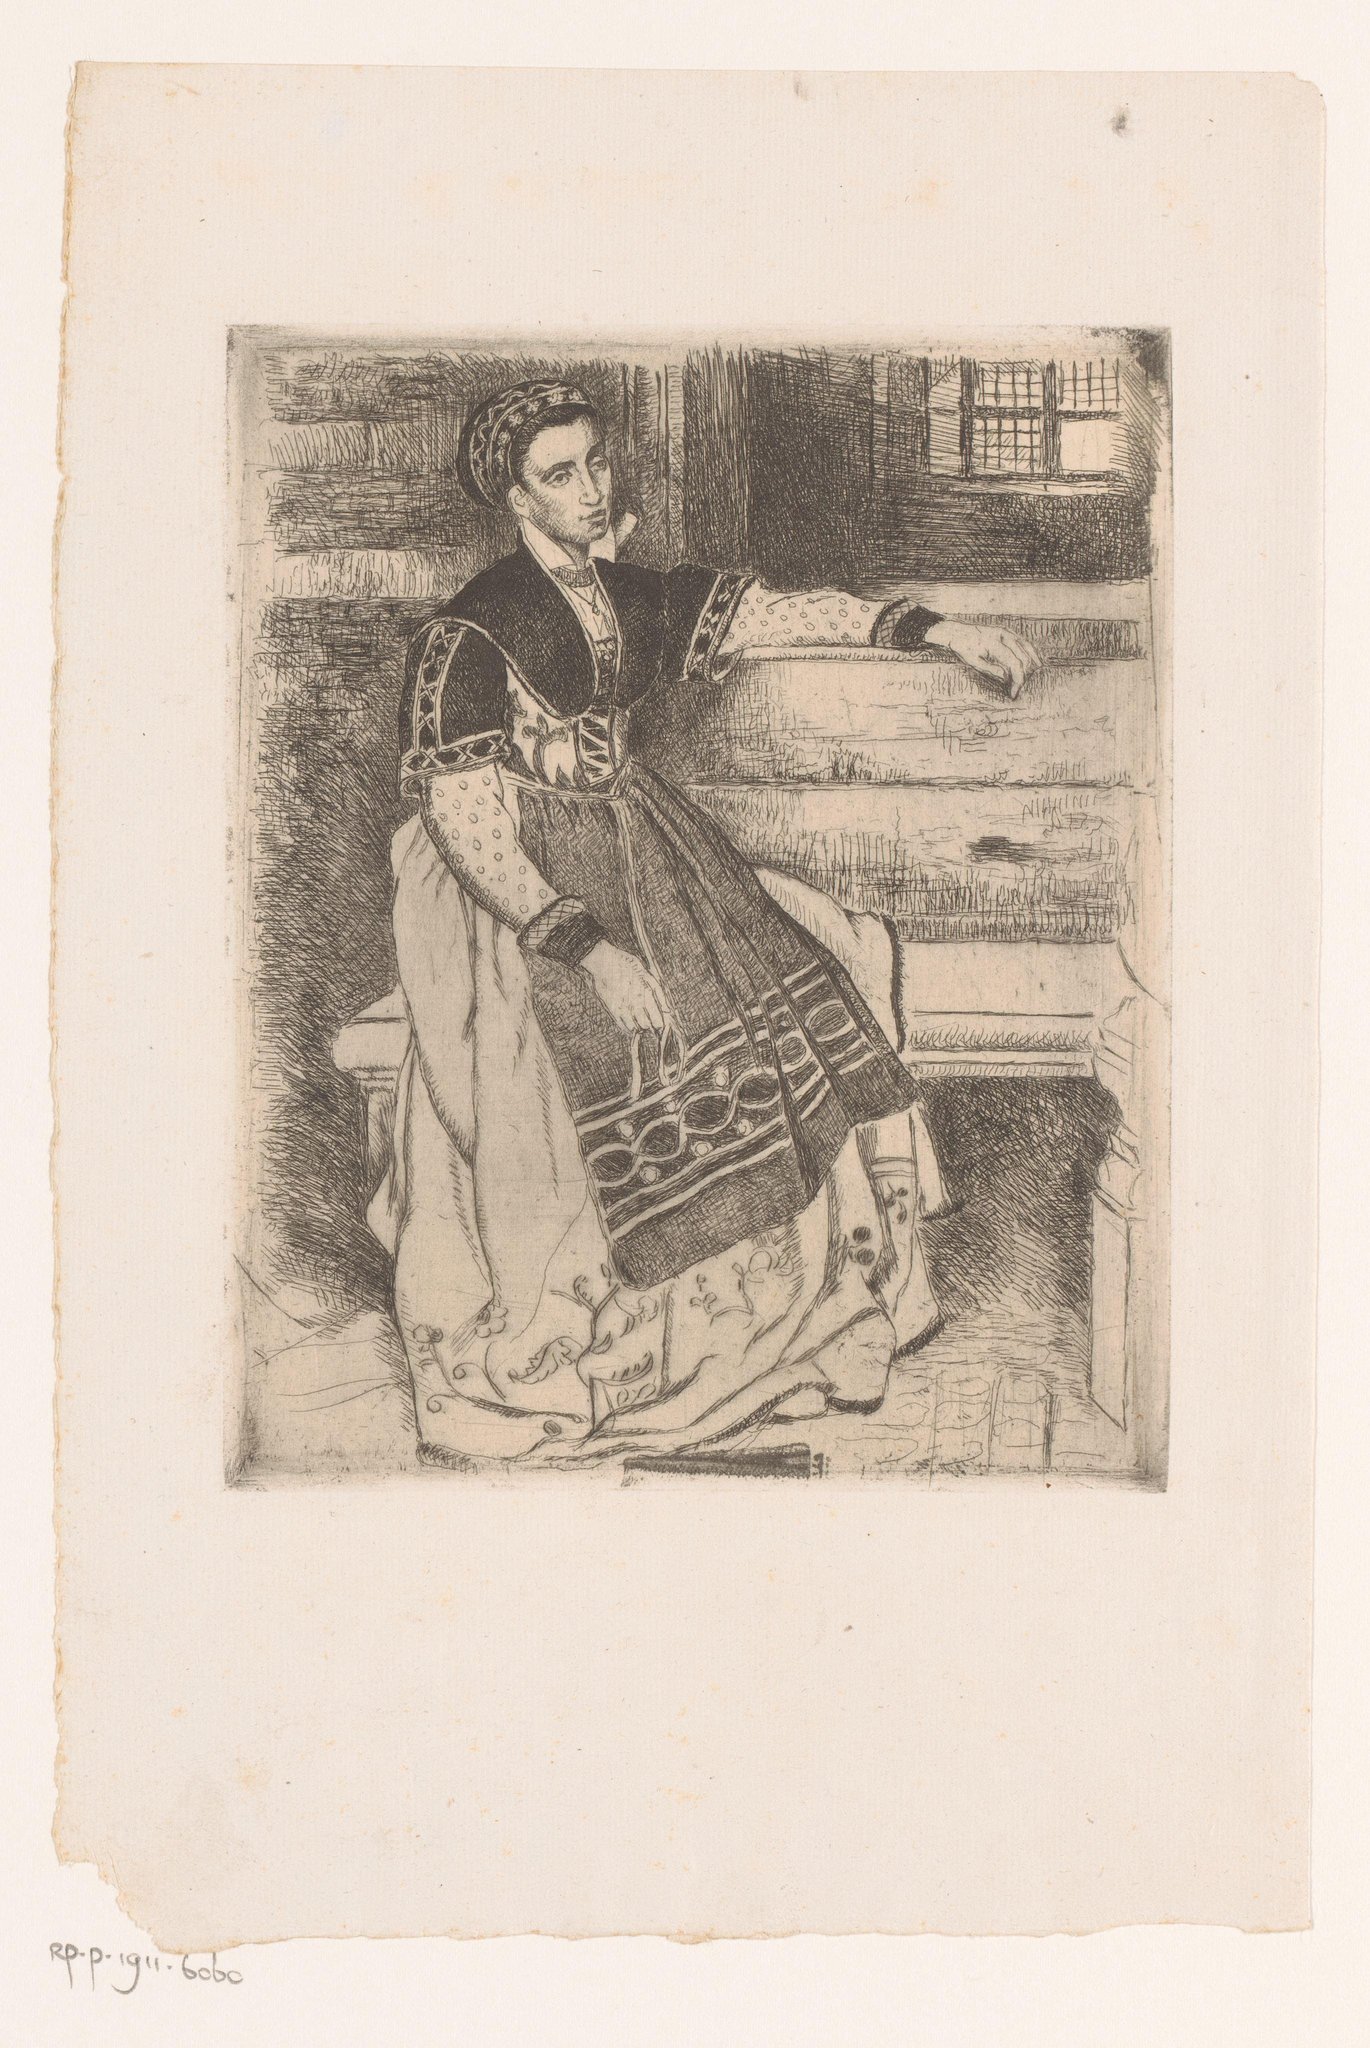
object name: print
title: Jonge vrouw zit aan het raam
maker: henri leys (baron)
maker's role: draughtsman, painter, print maker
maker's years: 1815-1869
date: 1825-1869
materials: paper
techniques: drypoint, etching, intaglio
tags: adult woman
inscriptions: collector's mark: Lugt 2228